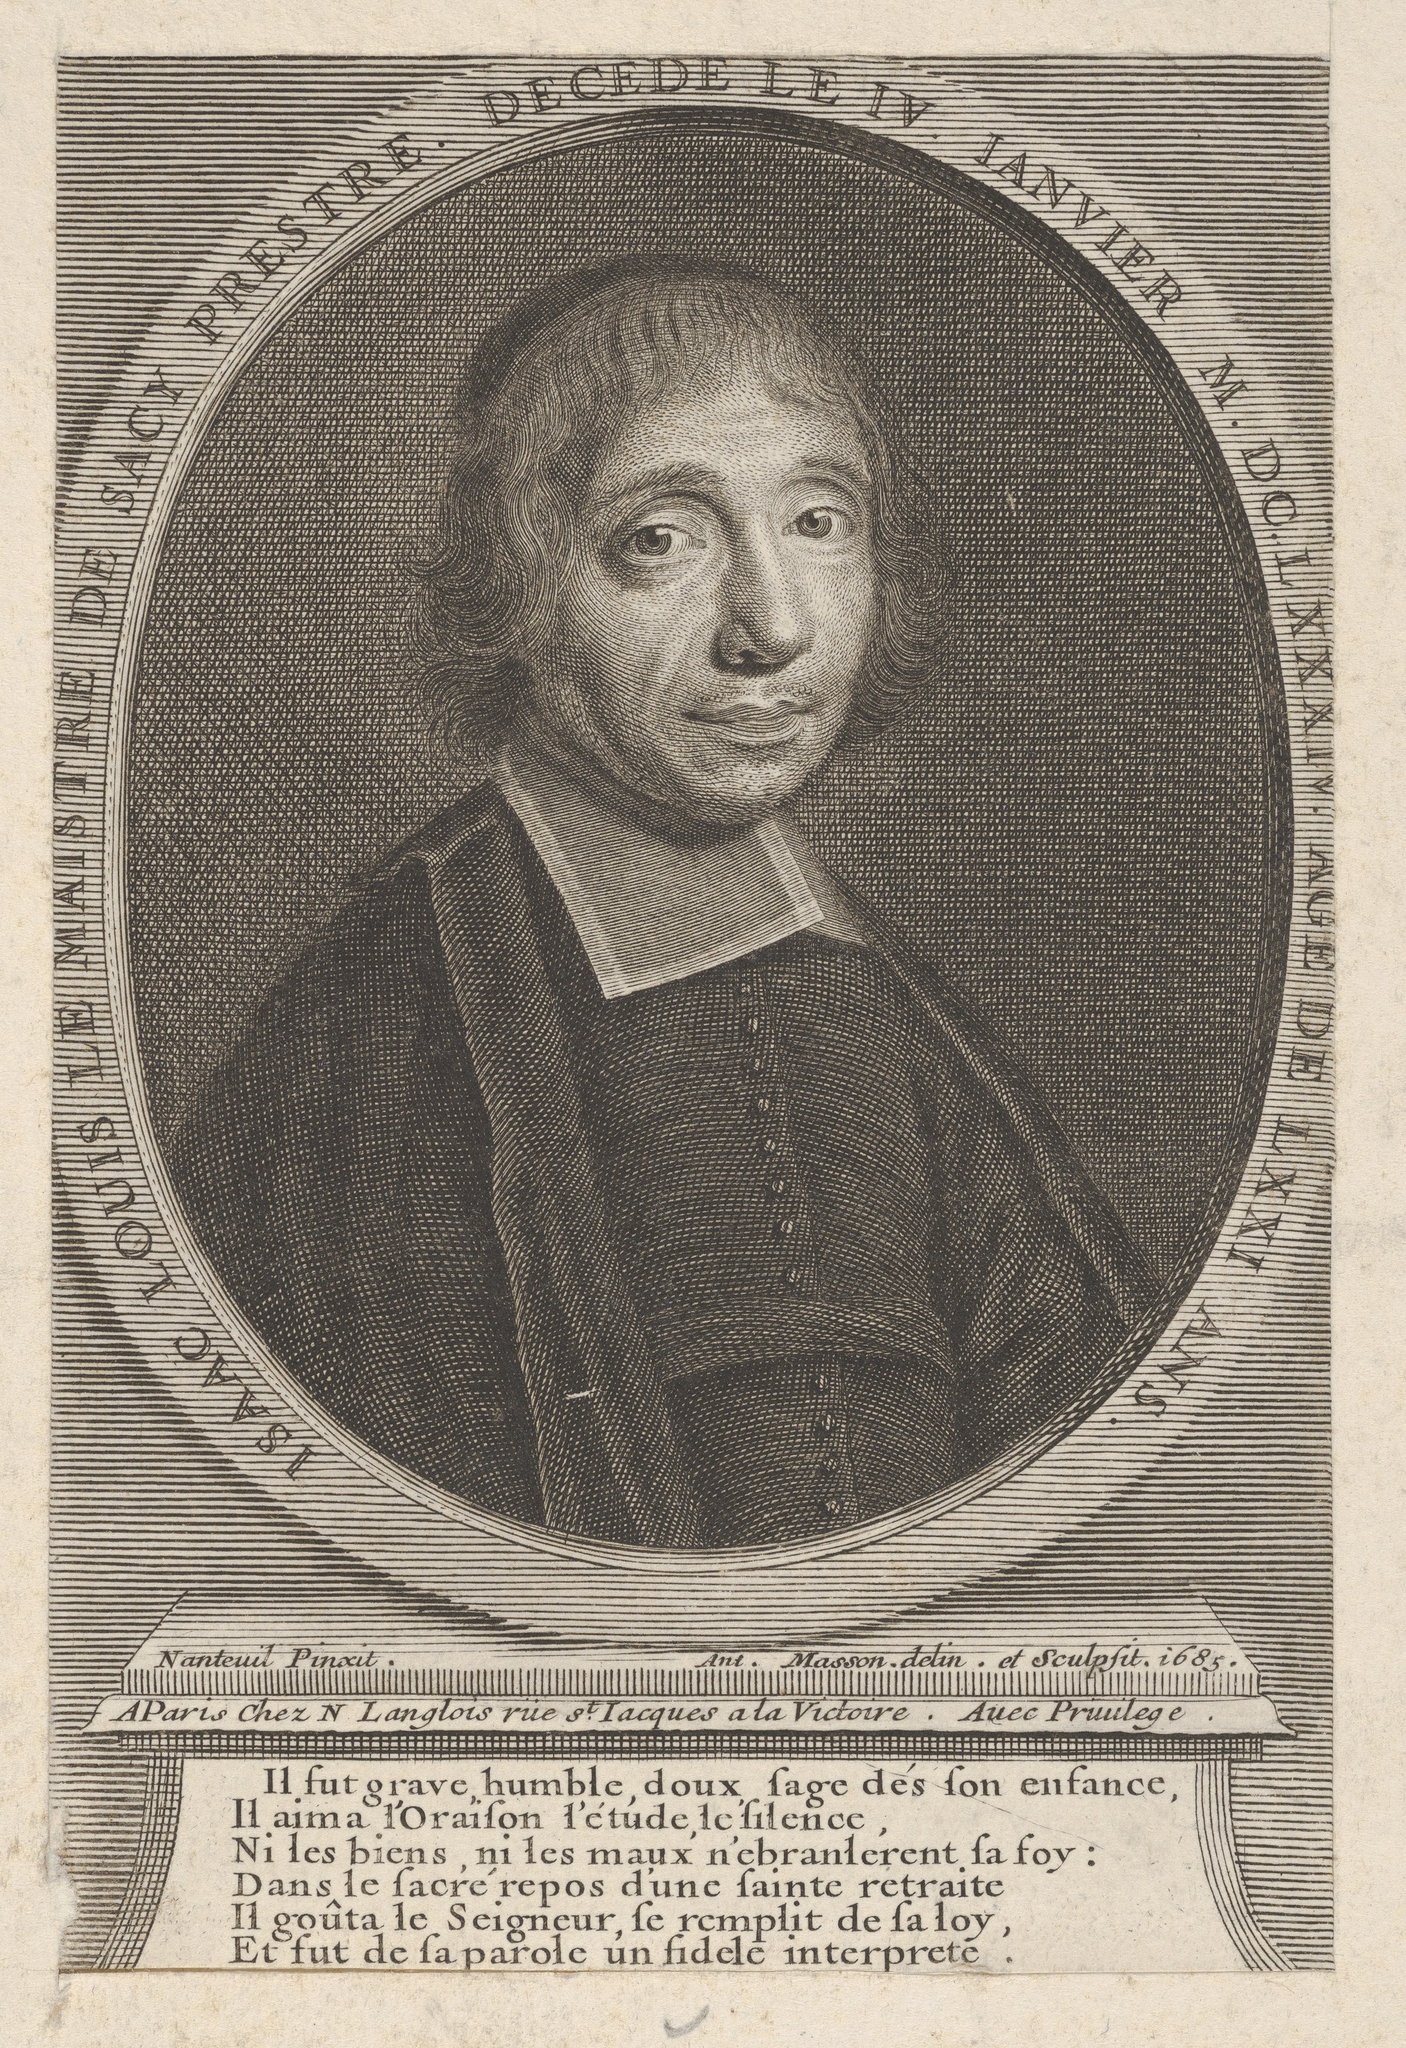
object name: print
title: Louis-Isaac Lemaistre de Sacy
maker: antoine masson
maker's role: artist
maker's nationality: french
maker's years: 1636-1700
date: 1661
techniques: engraving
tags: men,portraits